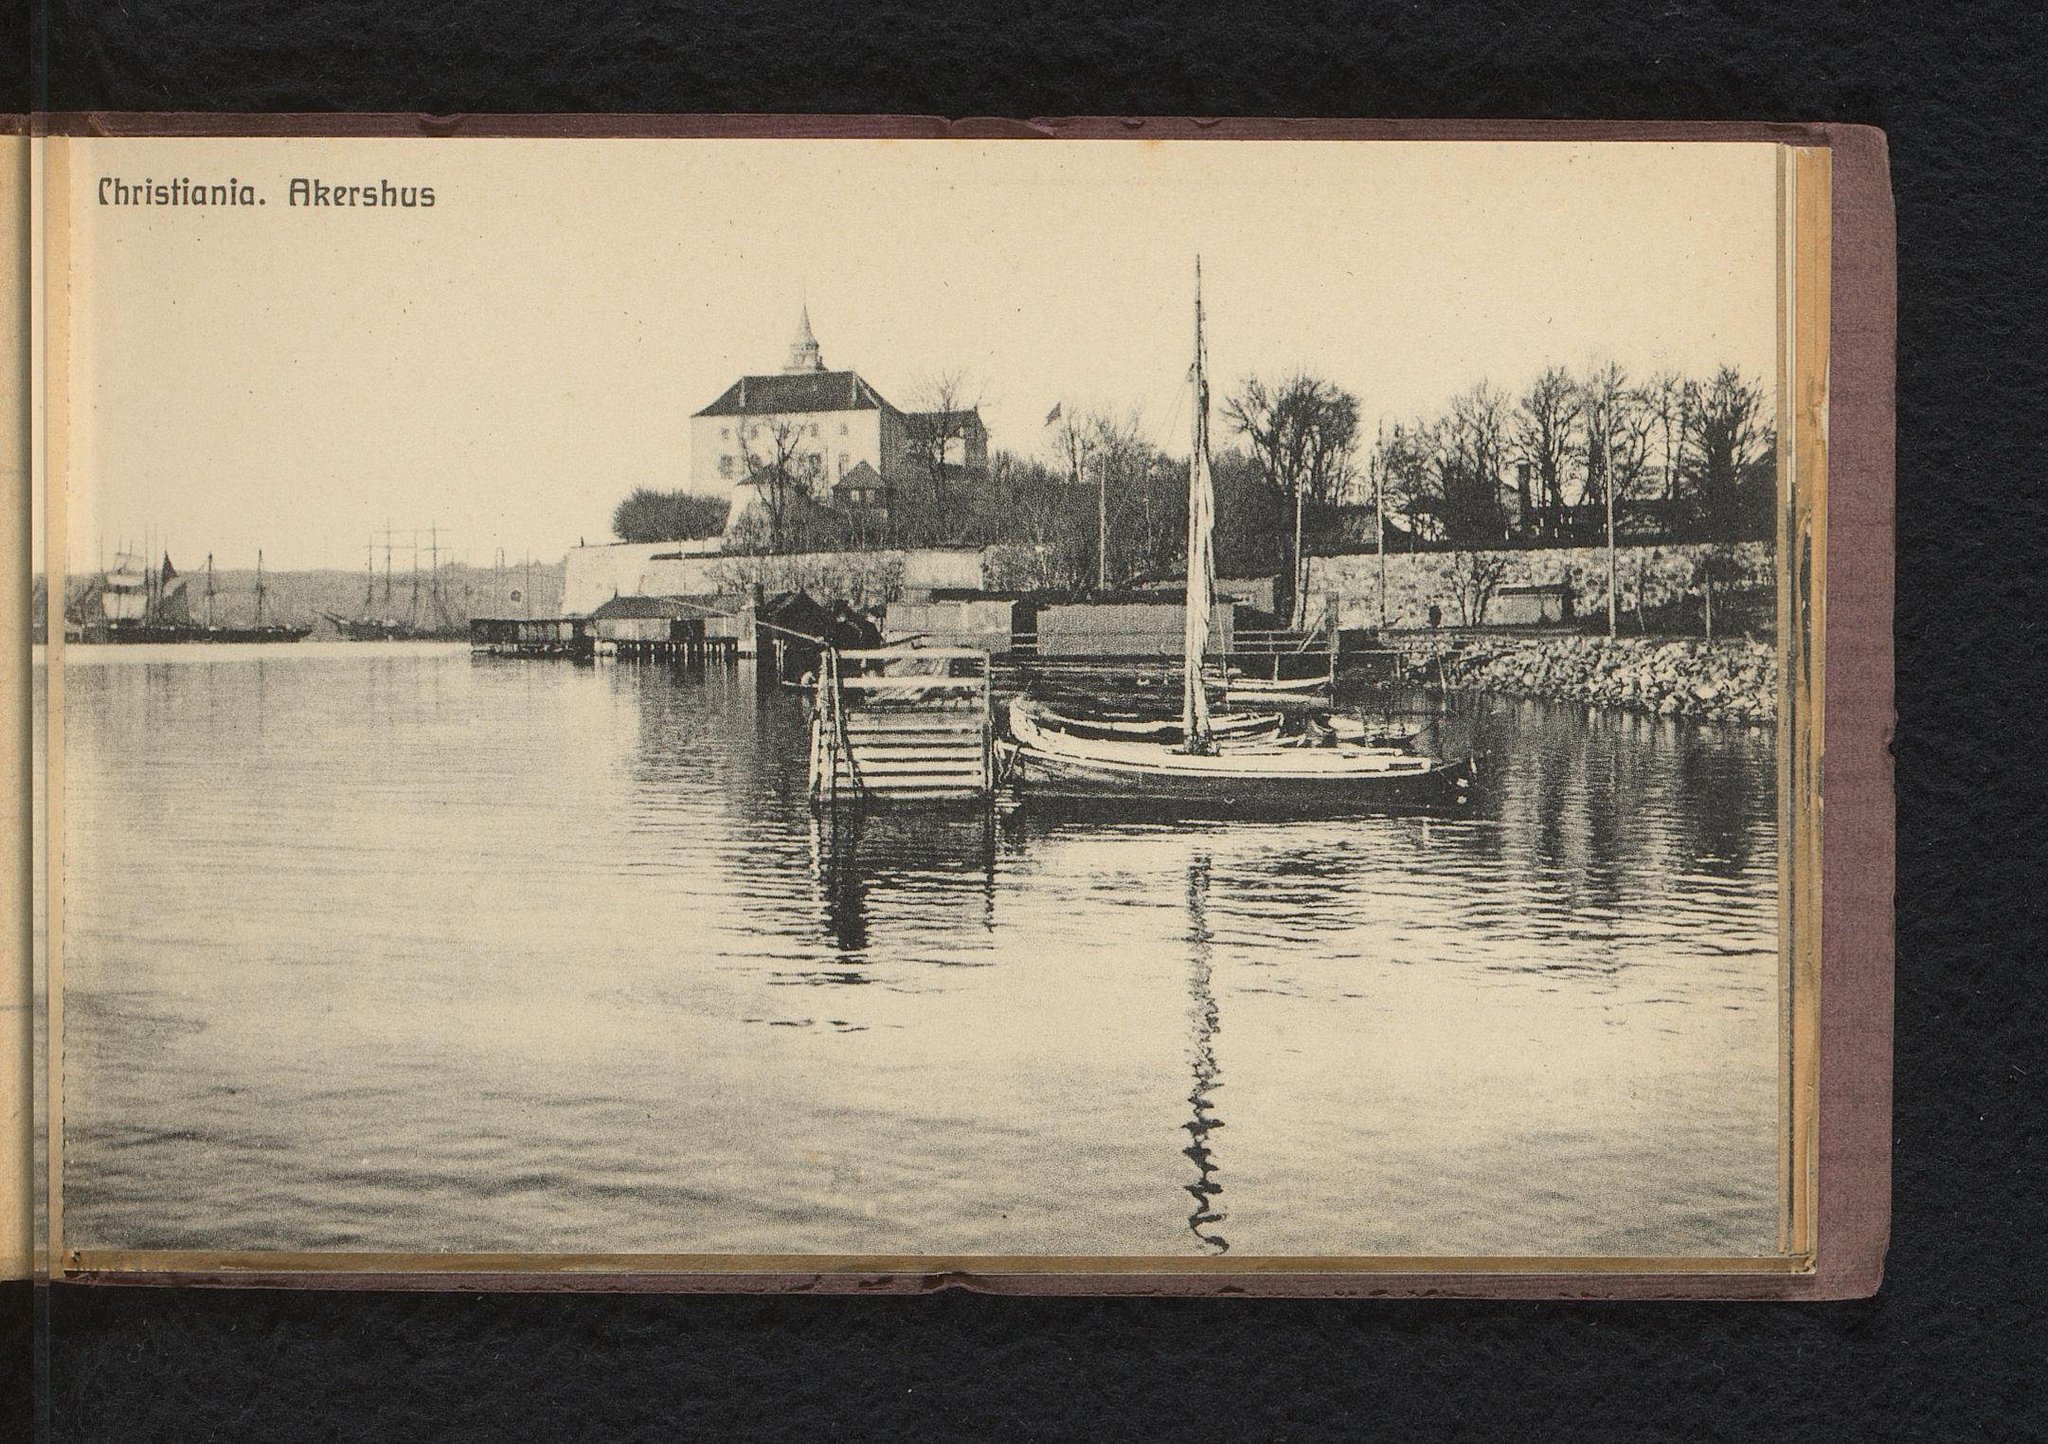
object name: photomechanical print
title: Christiania. Akershus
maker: Anonymous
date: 1904-1925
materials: cardboard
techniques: photograph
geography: oslo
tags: castle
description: Prentbriefkaart maakt deel uit van een album.